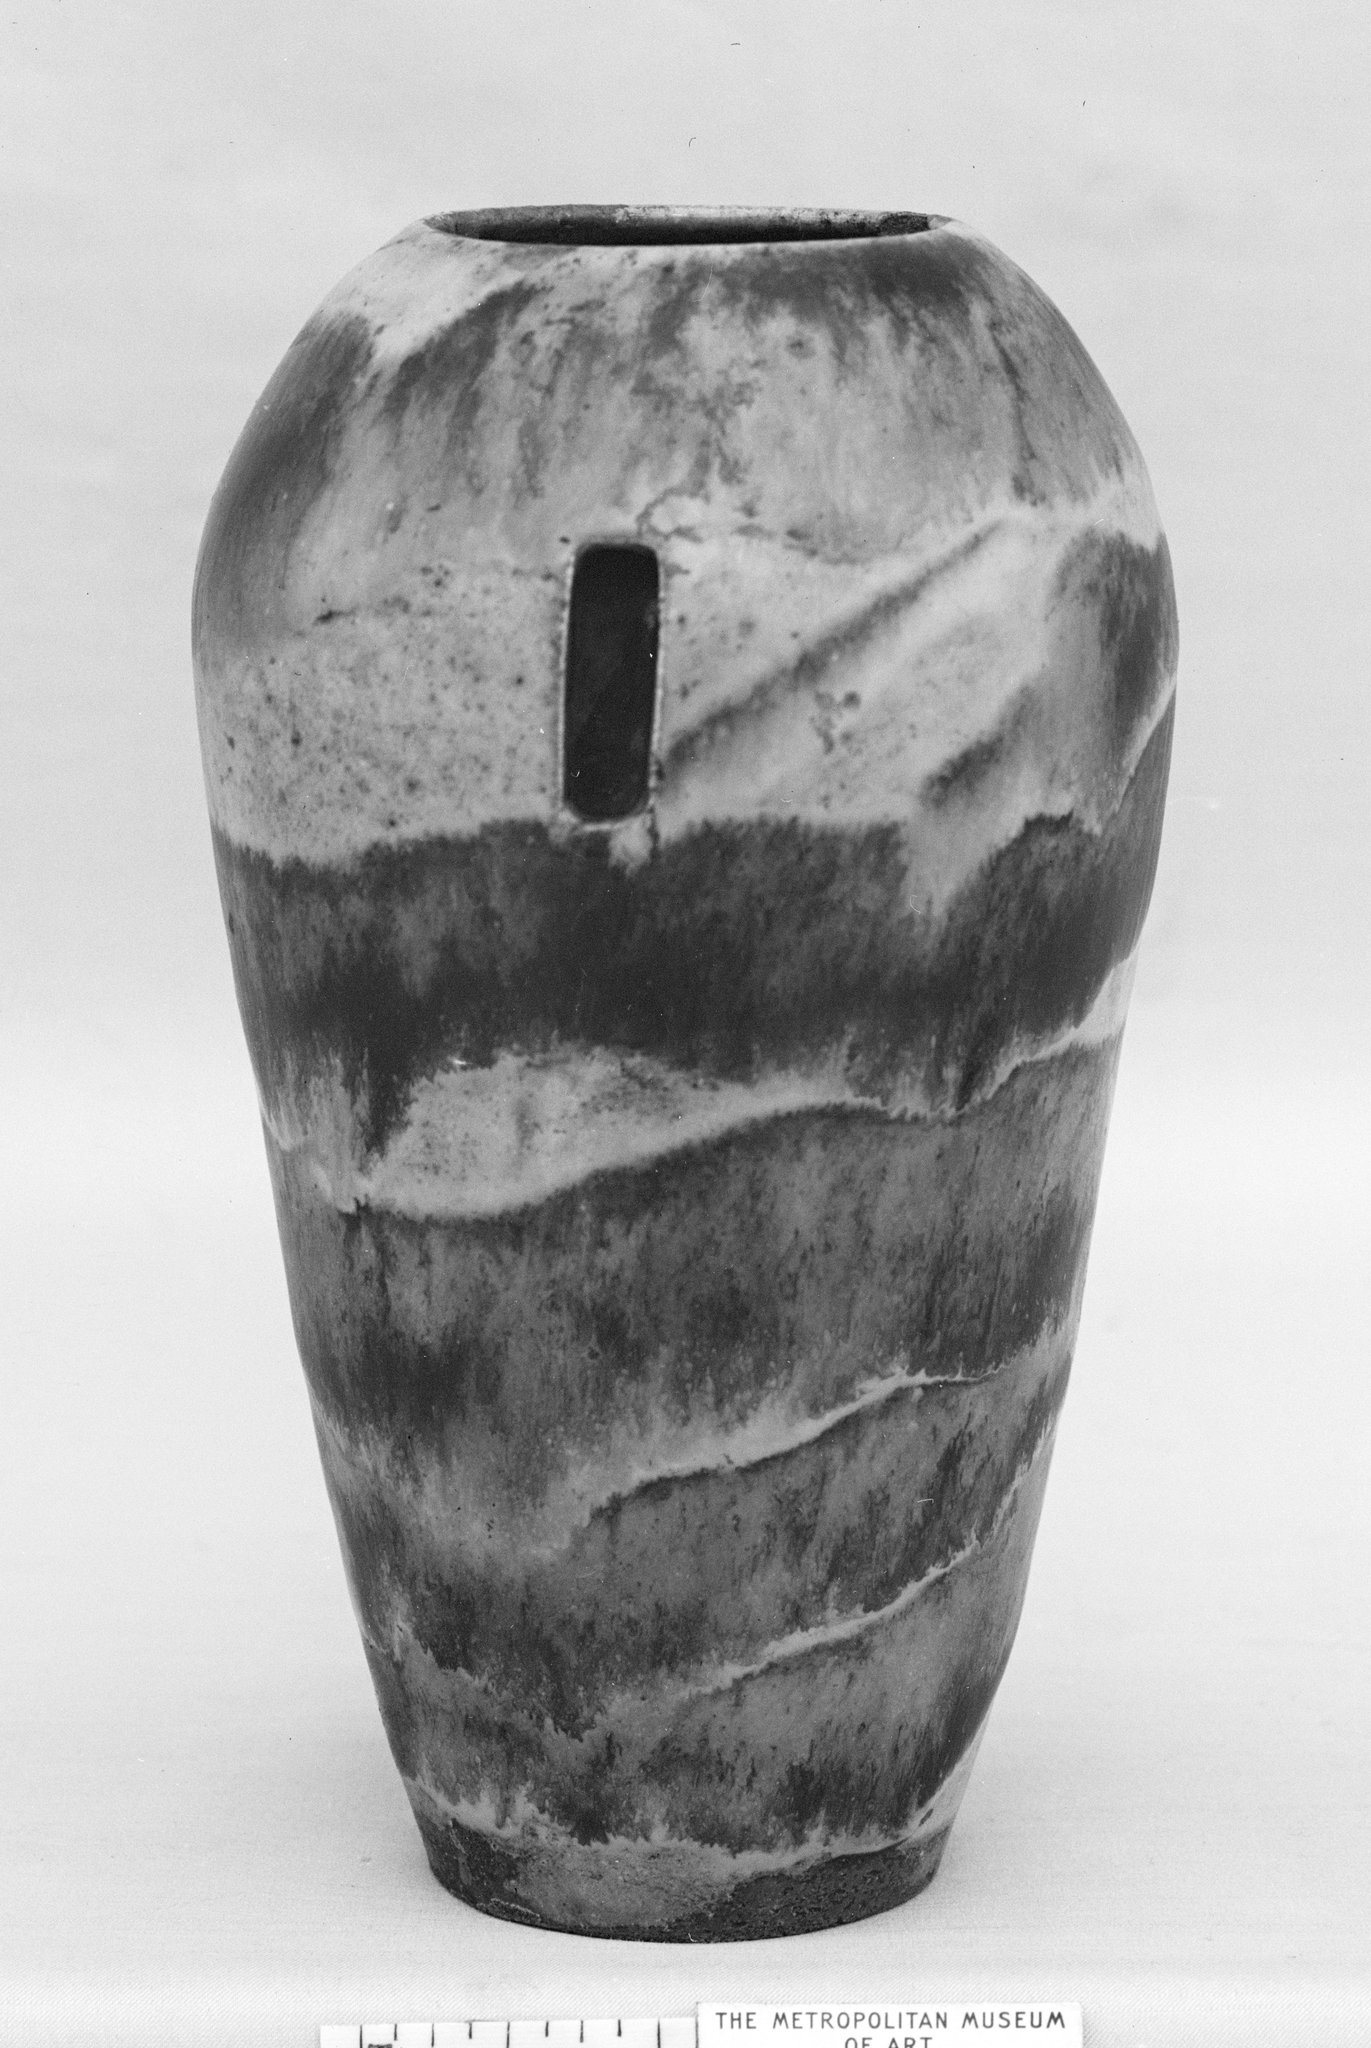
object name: hanging vase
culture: japanese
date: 1801-1900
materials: paste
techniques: polychrome